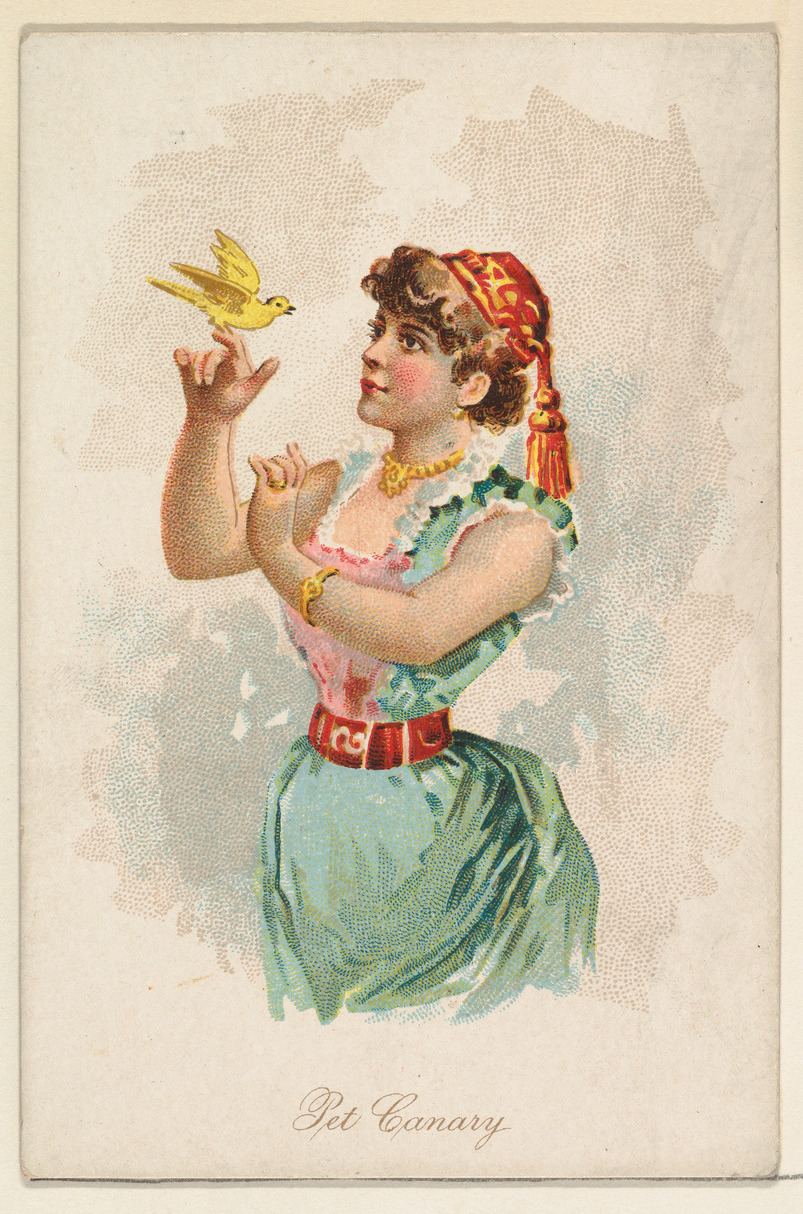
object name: print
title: Pet Canary, from the Household Pets series (N194) issued by Wm. S. Kimball & Co.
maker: william s. kimball & company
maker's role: publisher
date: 1891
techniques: color lithograph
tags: birds,women